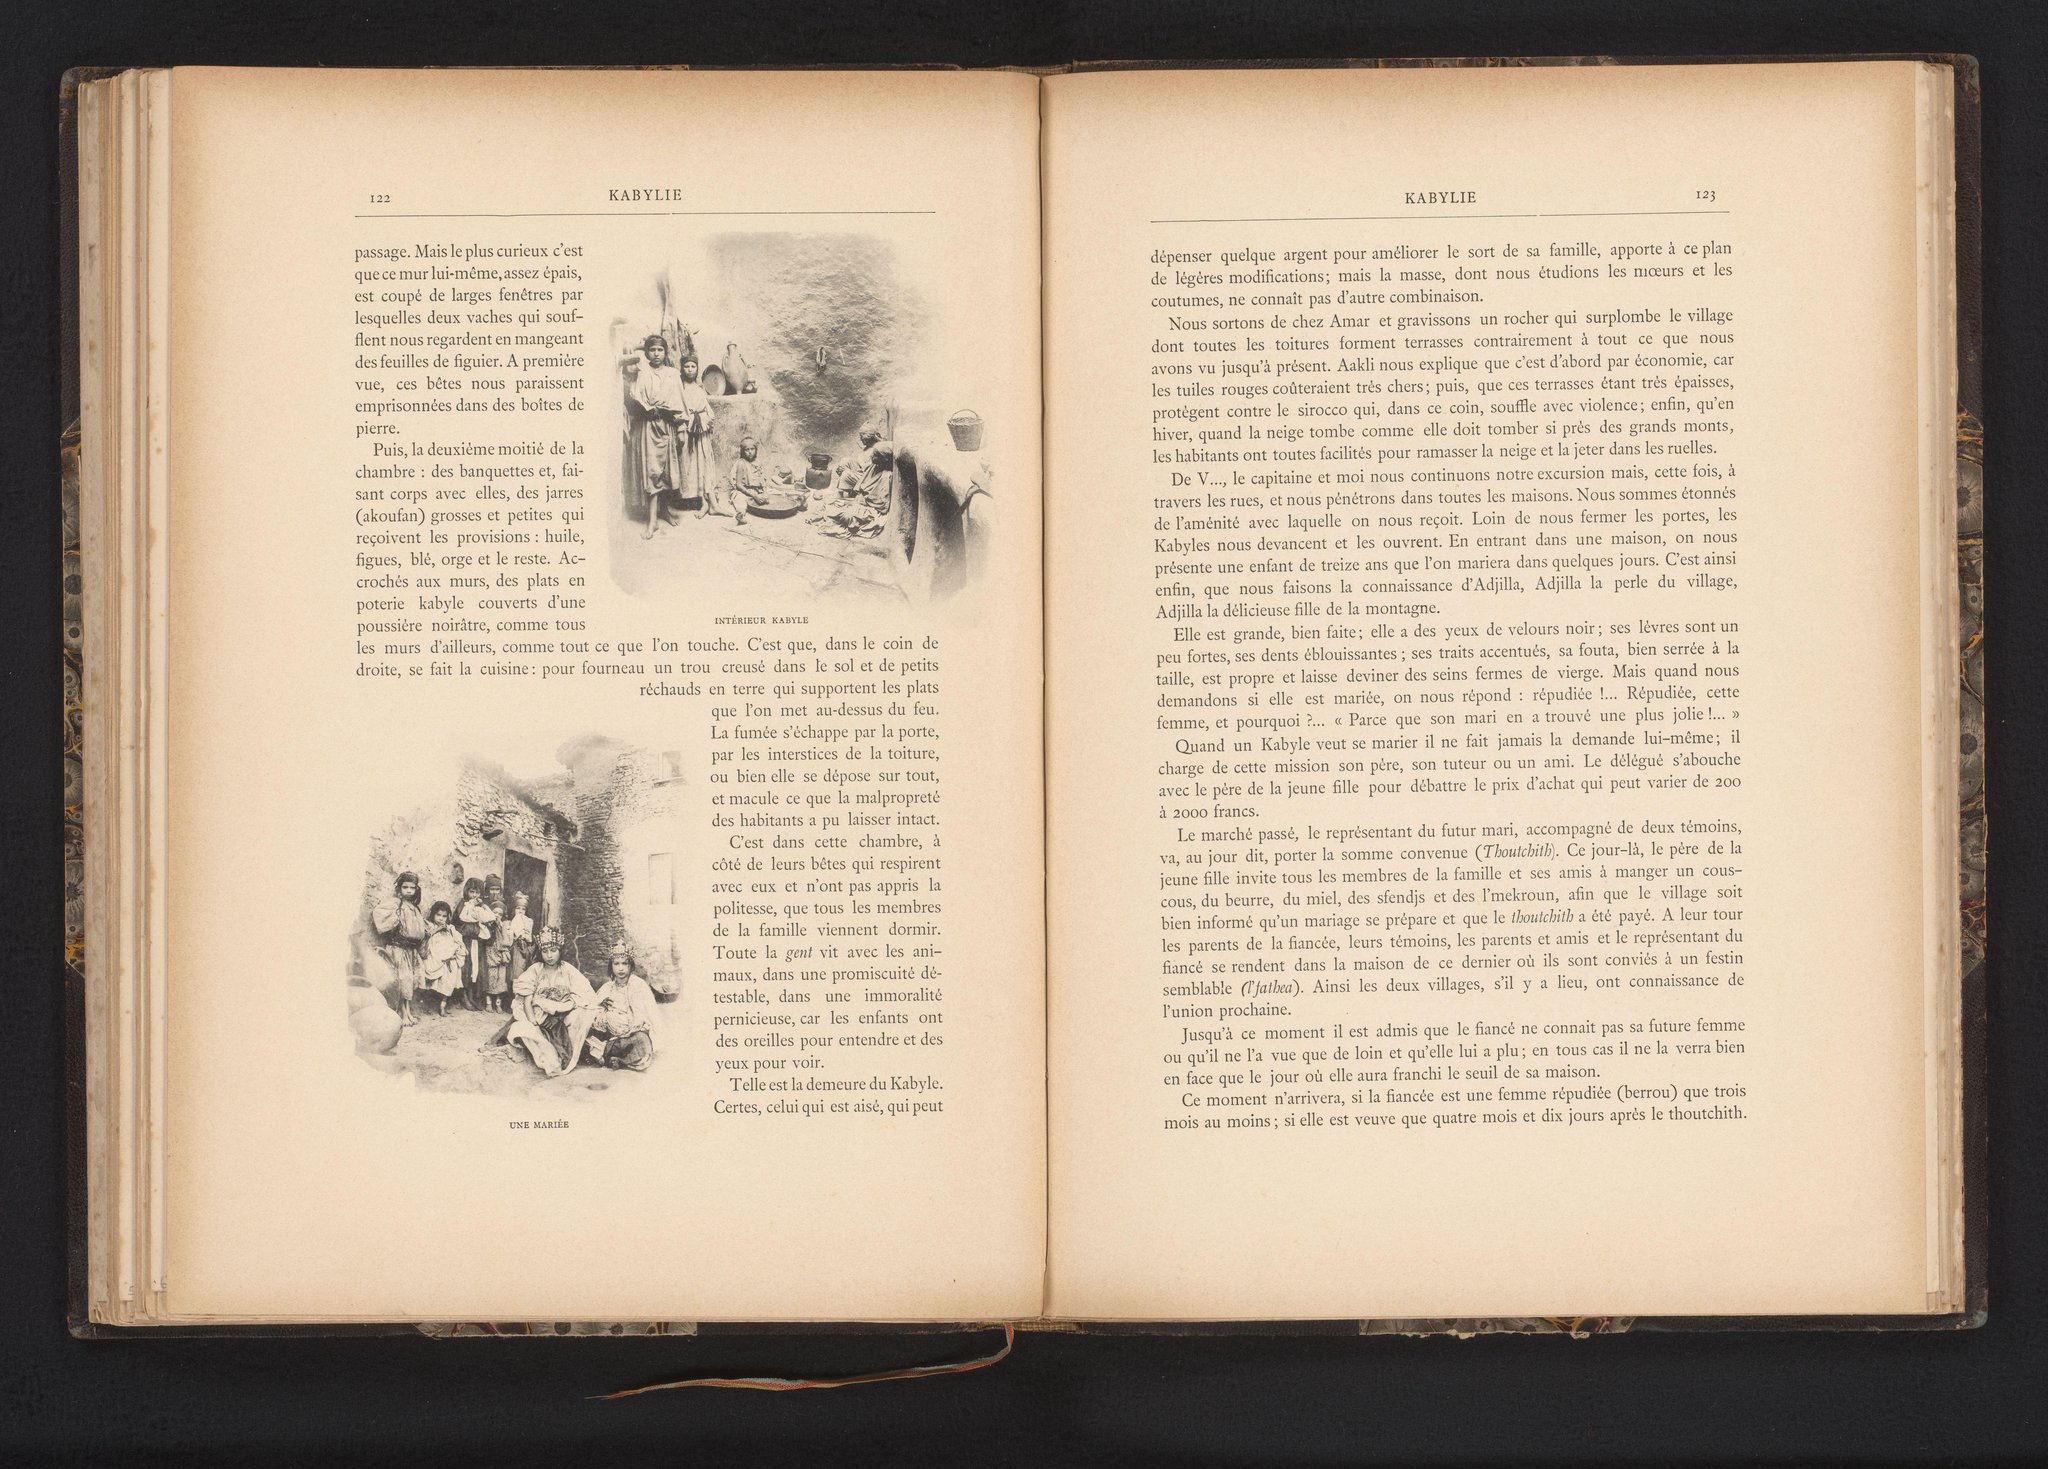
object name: photomechanical print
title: Kabylische bruid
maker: jules gervais-courtellemont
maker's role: fotograaf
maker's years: 1863-1931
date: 1888-1893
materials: paper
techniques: photograph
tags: bride (in wedding-dress)